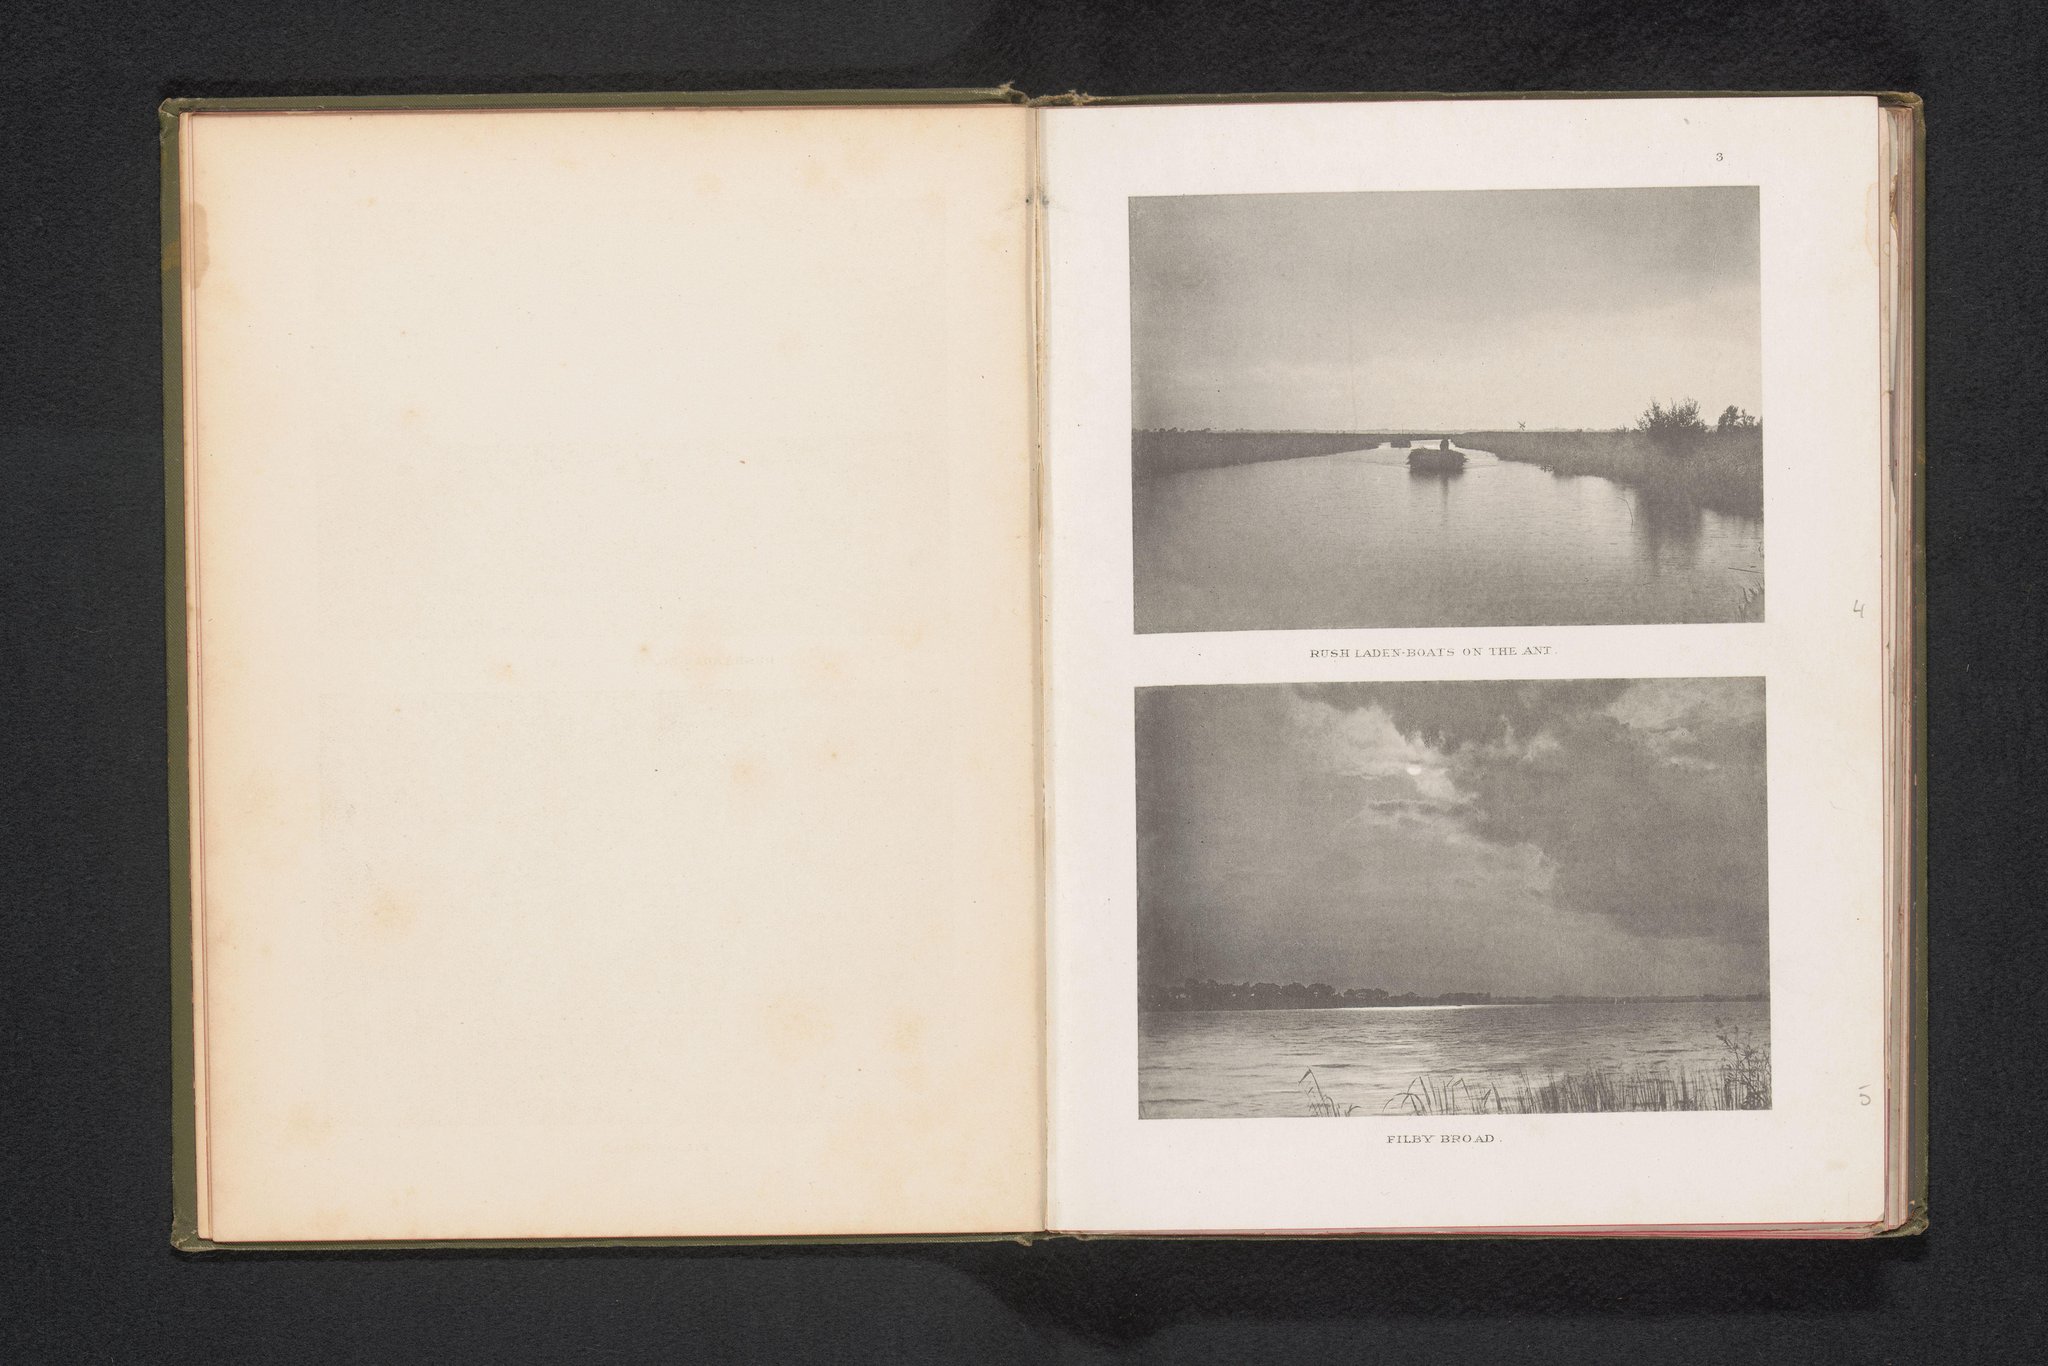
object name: photomechanical print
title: Met riet beladen boten op een rivier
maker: john payne jennings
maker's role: fotograaf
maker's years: 1843-1926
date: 1886-1891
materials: paper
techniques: photograph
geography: norfolk broads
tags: river, landscapes with waters, waterscapes, seascapes (in the temperate zone)